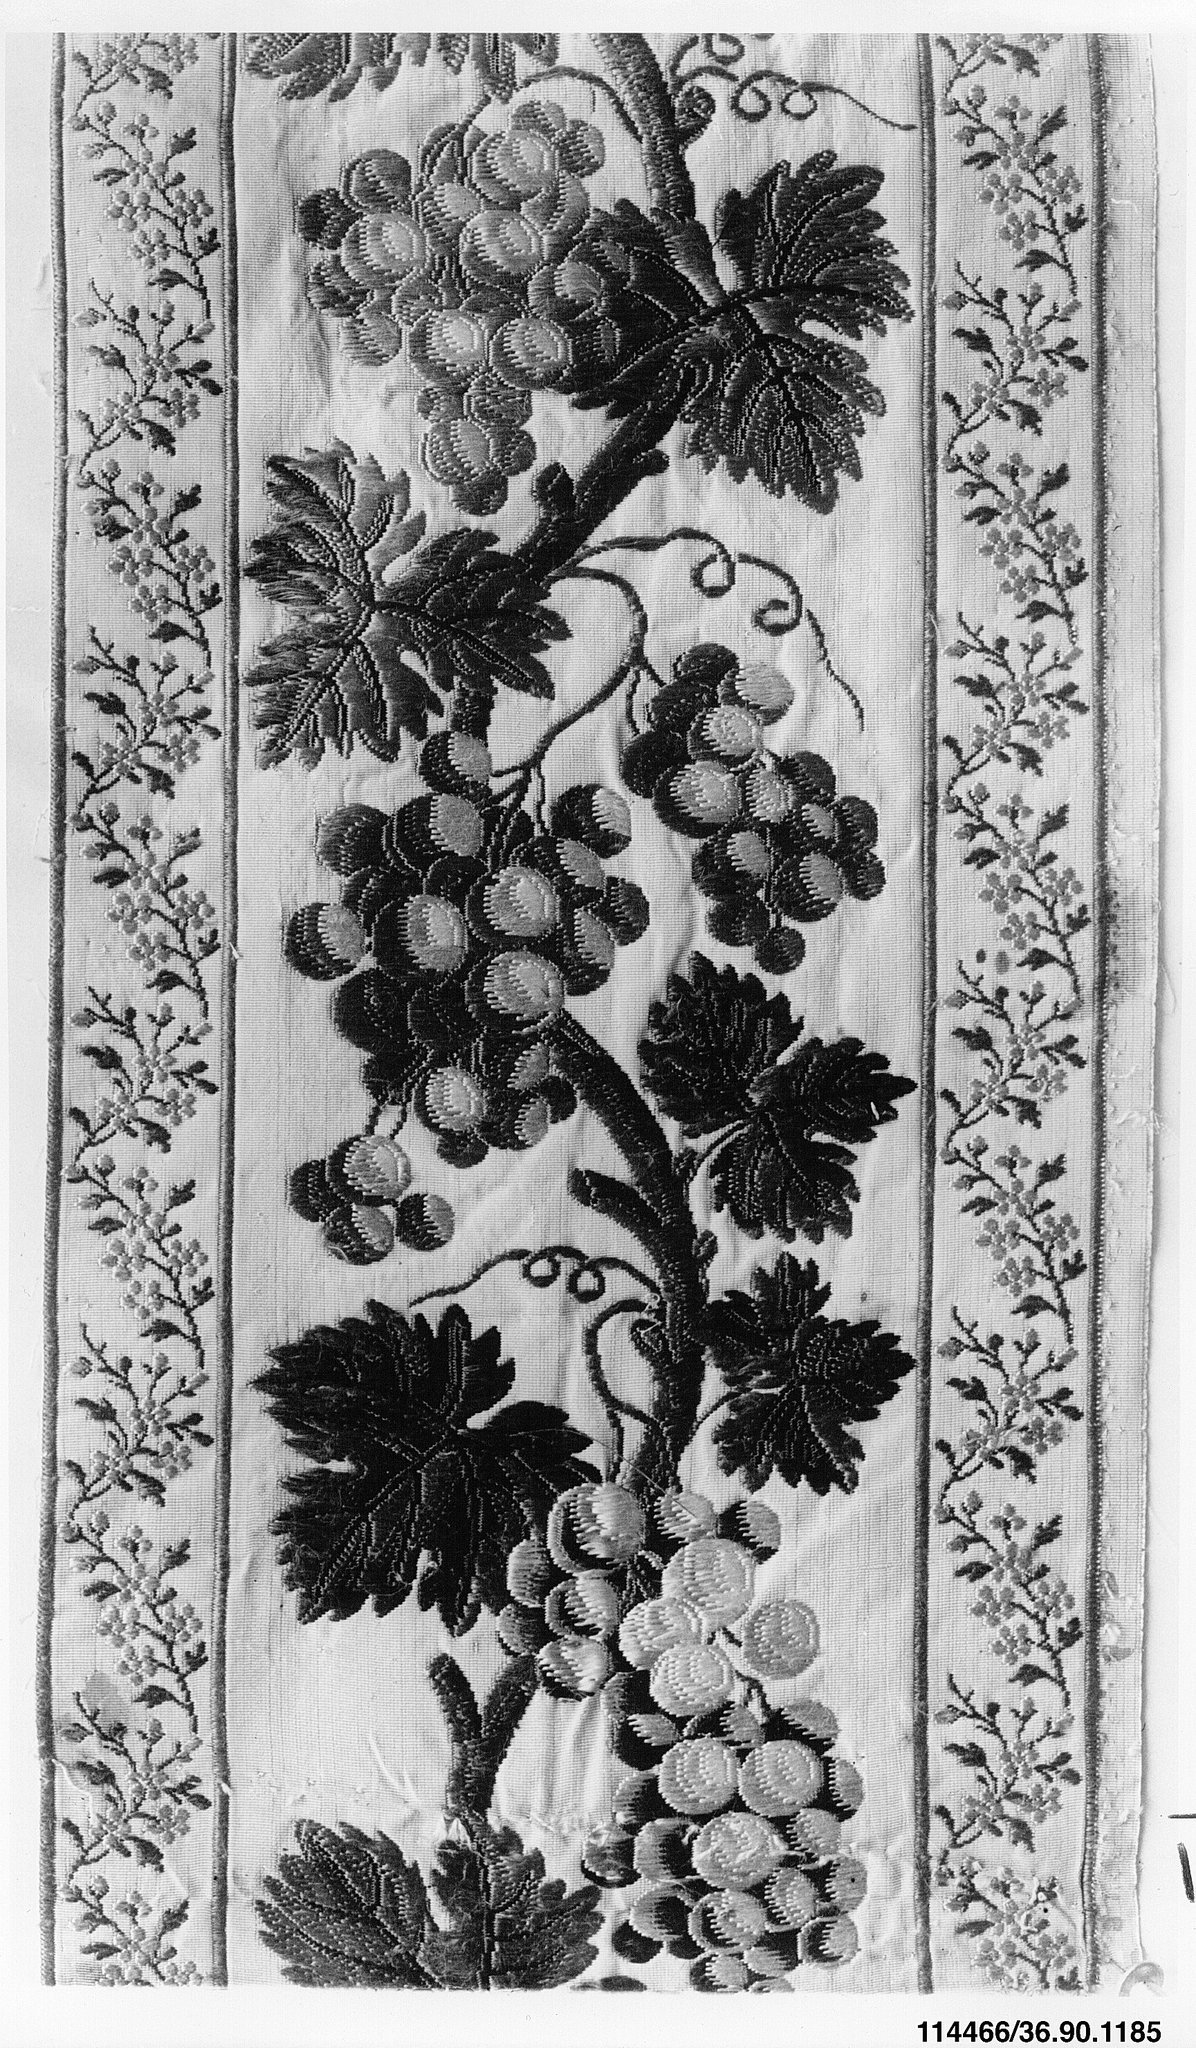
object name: piece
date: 1836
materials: silk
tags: grapes,leaves